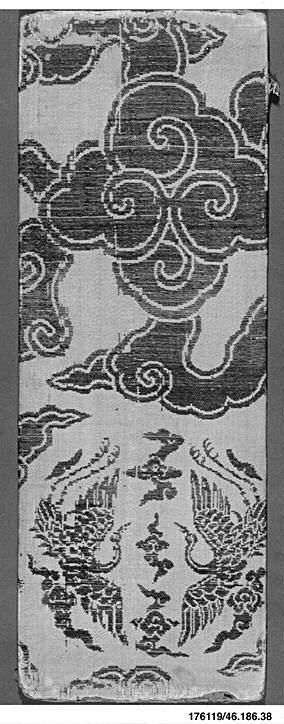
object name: sutra cover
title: Sutra Cover with Clouds and Cranes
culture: chinese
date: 1501-1600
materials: silk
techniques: patterning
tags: cranes,clouds